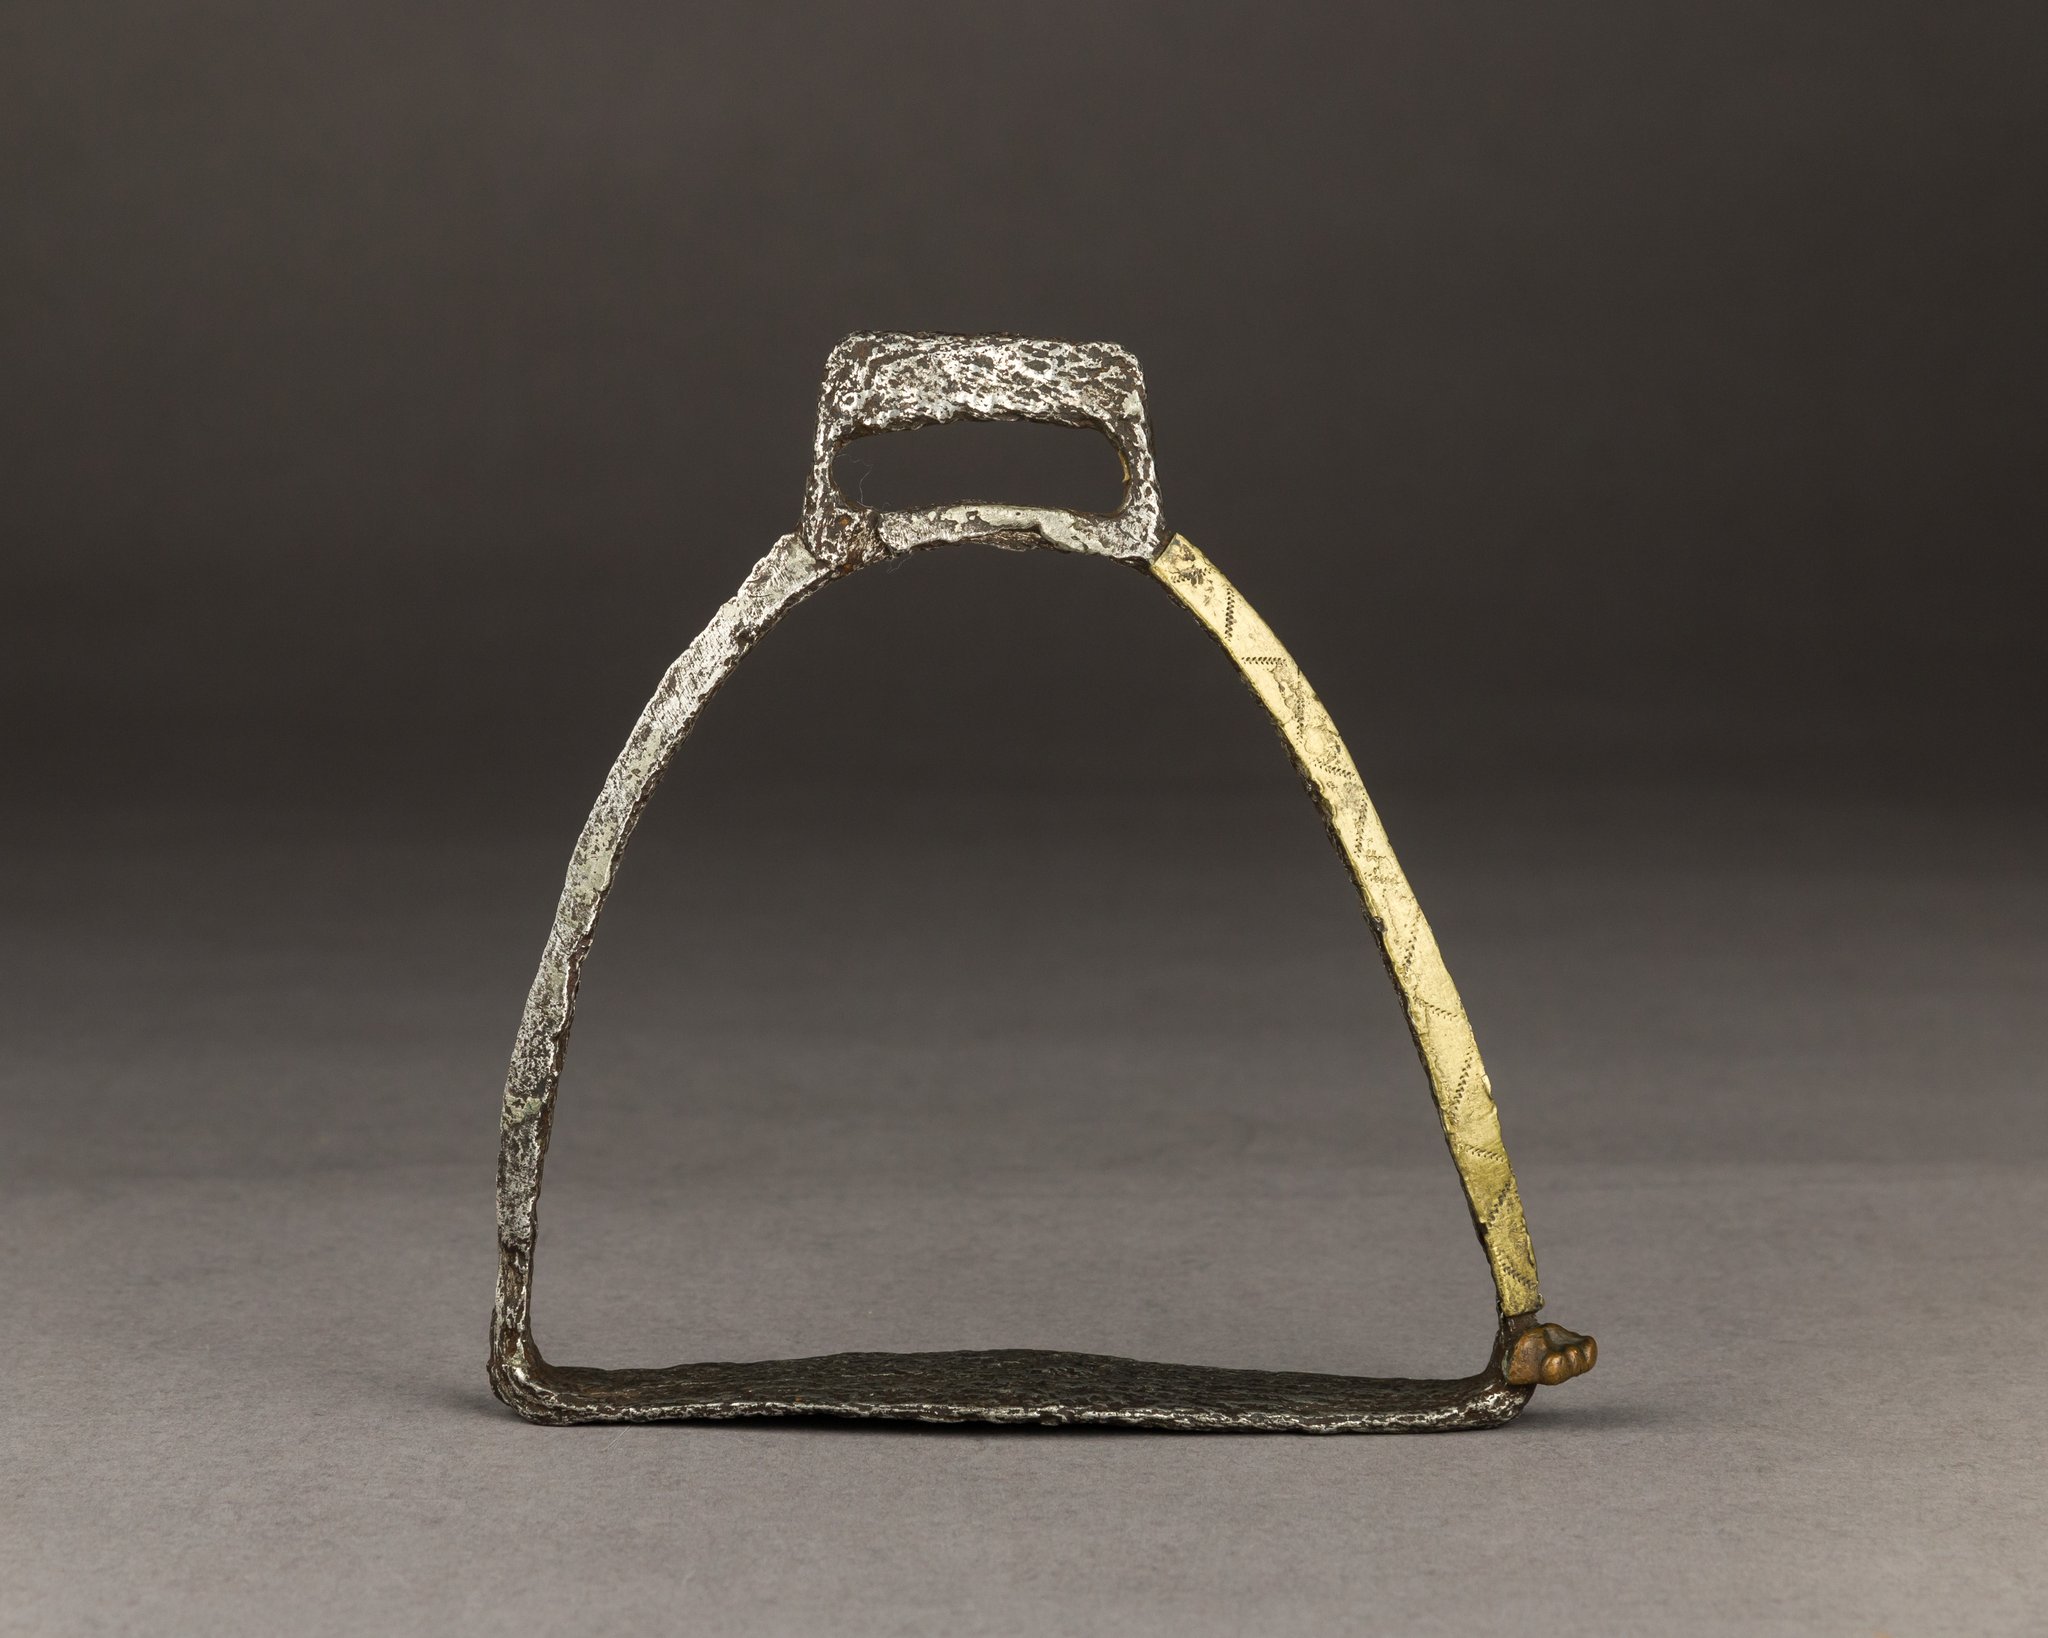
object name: stirrup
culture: german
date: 901-1100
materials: copper, iron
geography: germany